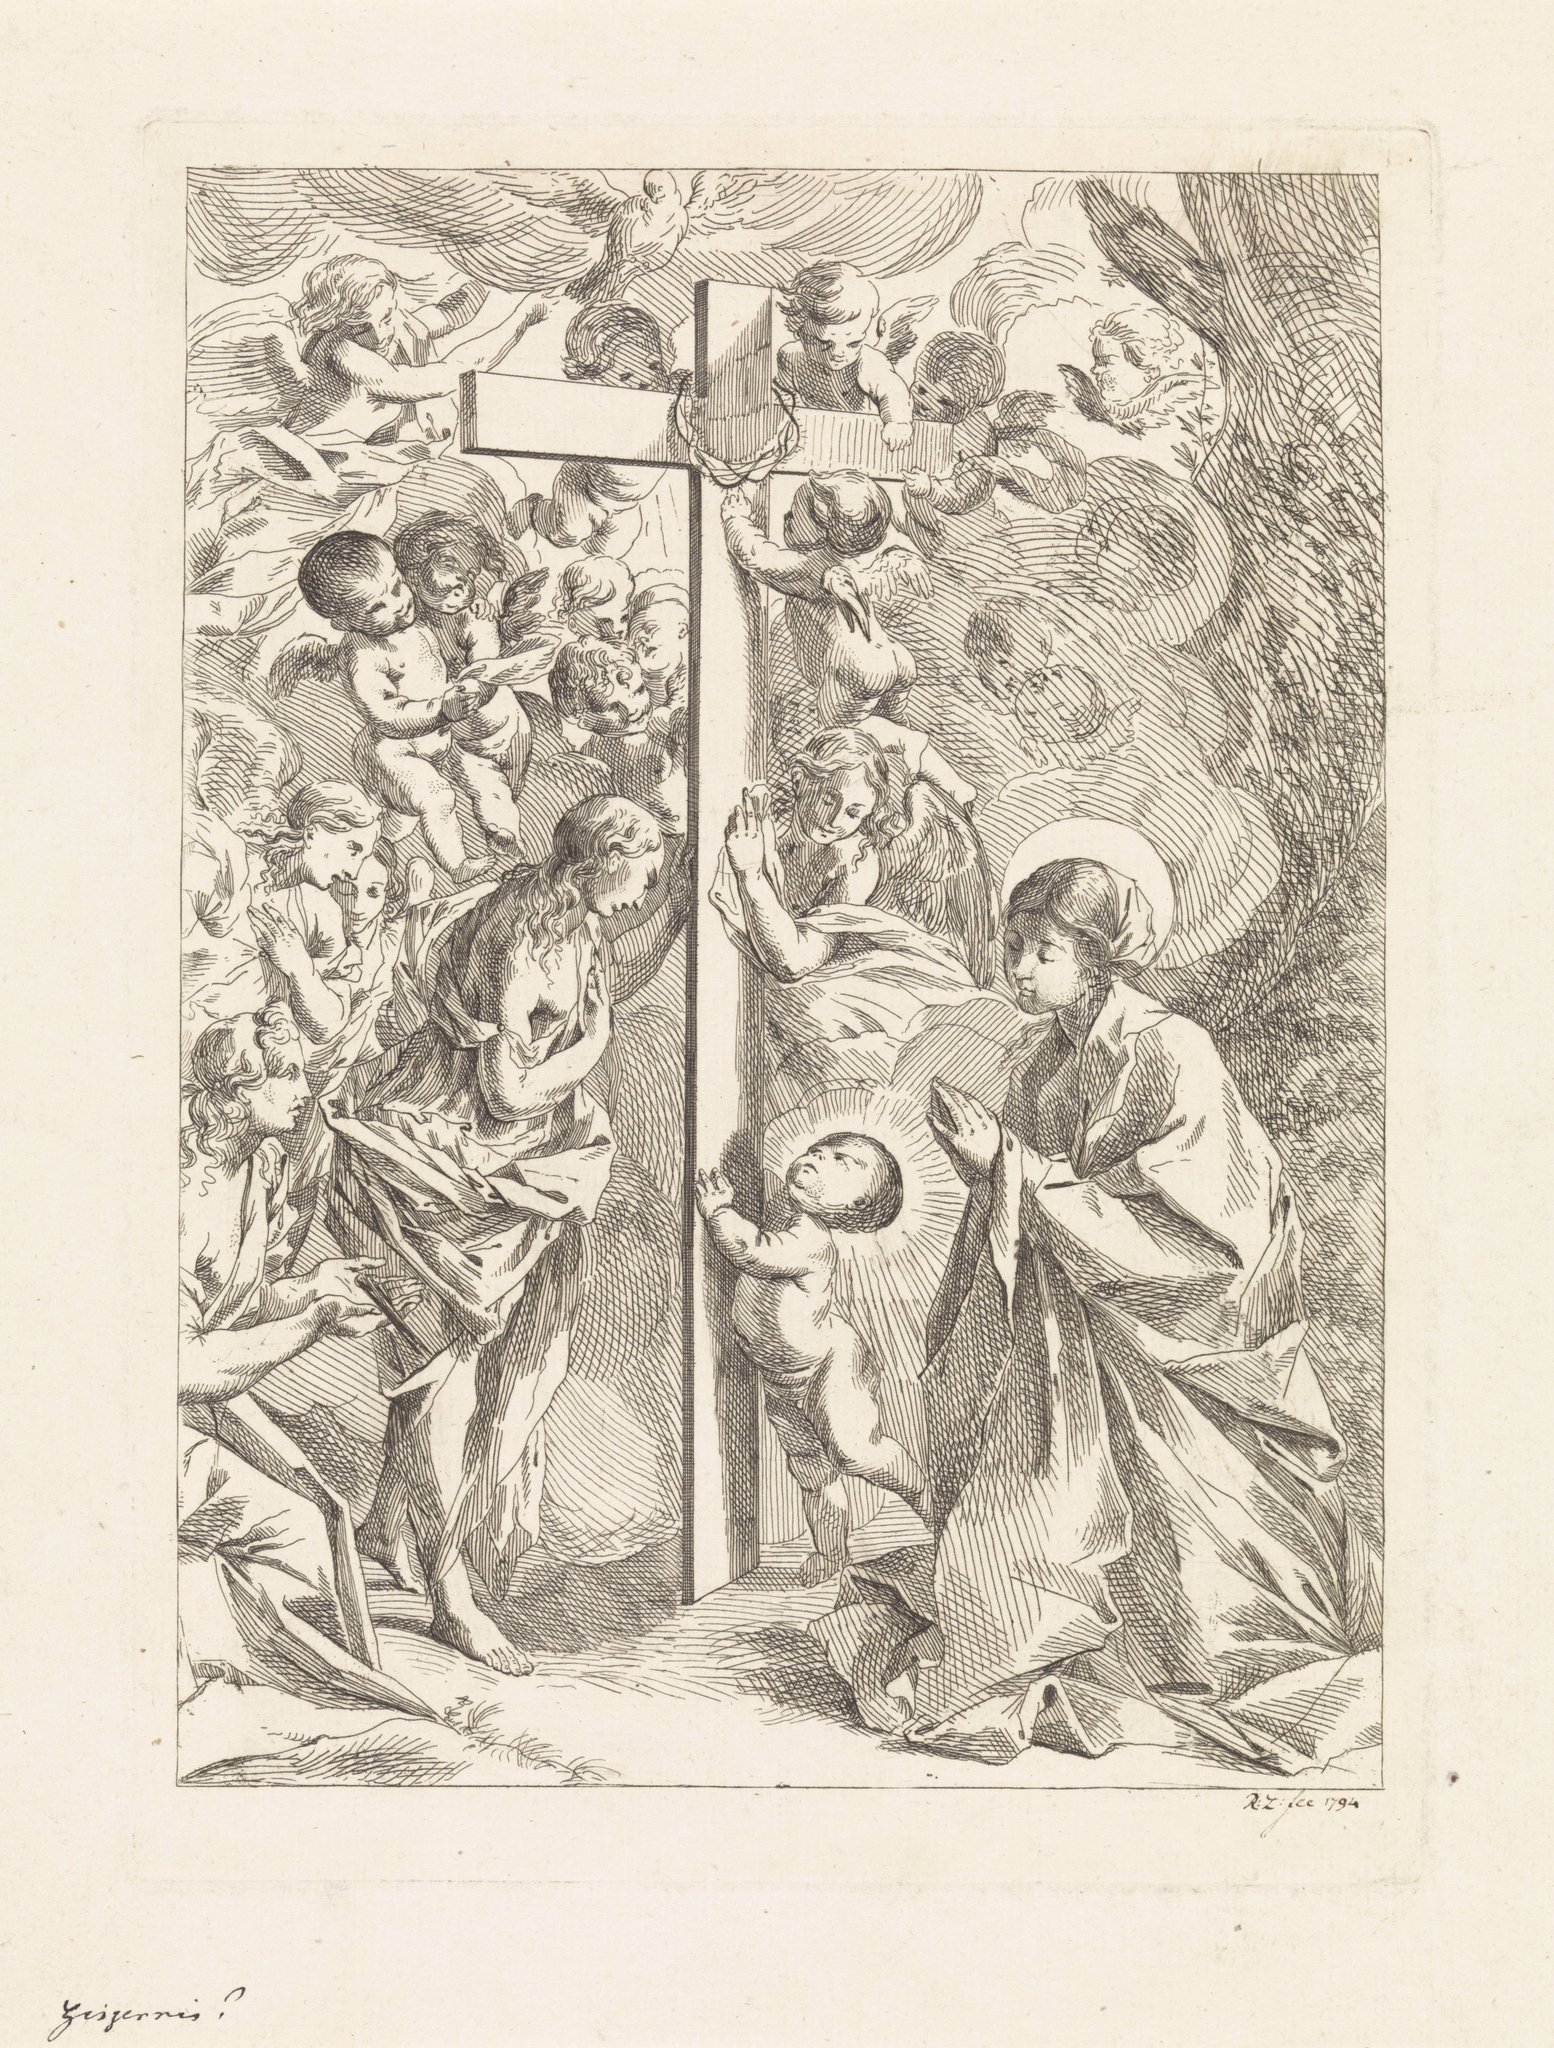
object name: print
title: Maria met Christuskind bij het kruis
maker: r. ziesenis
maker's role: print maker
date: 1794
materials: paper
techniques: etching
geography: netherlands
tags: mary kneeling (on the ground), the christ-child standing in front of her, angels, bystanders at the foot of the cross, among whom mary, mary magdalene and john the evangelist; mary may be shown swooning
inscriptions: collector's mark: Lugt 2228, inscription: ‘R:Z: fec 1794’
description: Maria met Christuskind bij het kruis, waaraan de doornenkroon hangt. Engelen en putti zweven rond het kruis. Links staan Maria Magdalena en Johannes. Geheel boven de duif van de Heilige Geest.